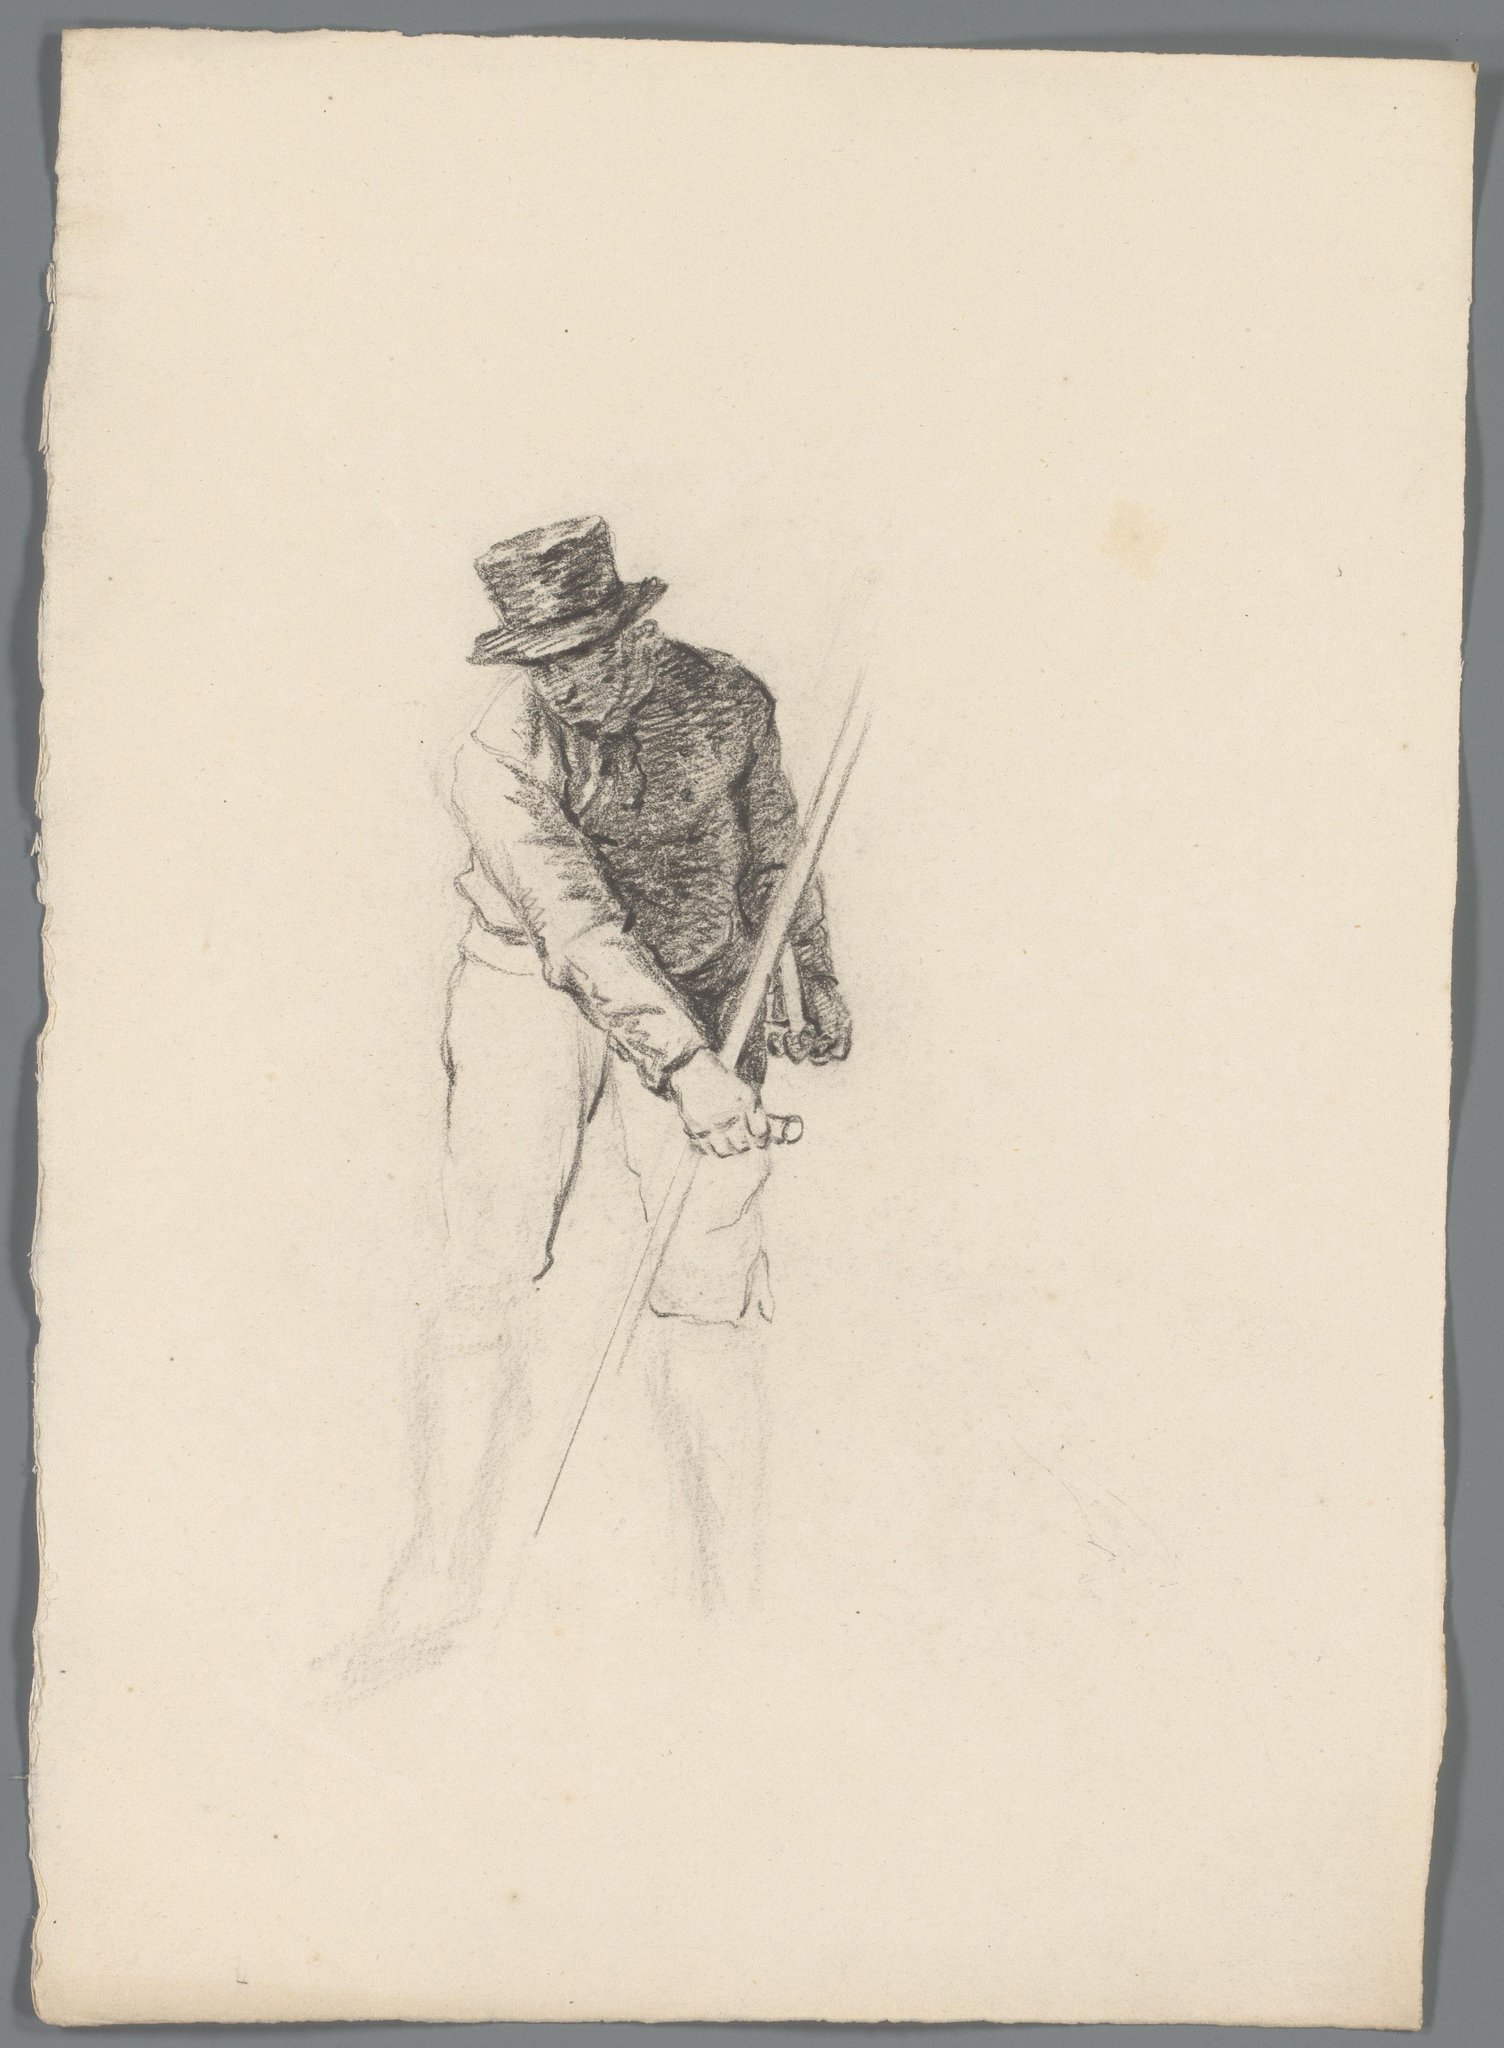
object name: drawing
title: Man met zeis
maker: Anonymous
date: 1820-1830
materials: chalk, paper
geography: the hague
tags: agricultural implements: scythe, adult man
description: Tekeningen waarschijnlijk ontstaan bij het Haagse kunstgenootschap ‘Tot Nut der Tekenkunst’, waar twee keer per week tekenavonden werden georganiseerd met geklede modellen.